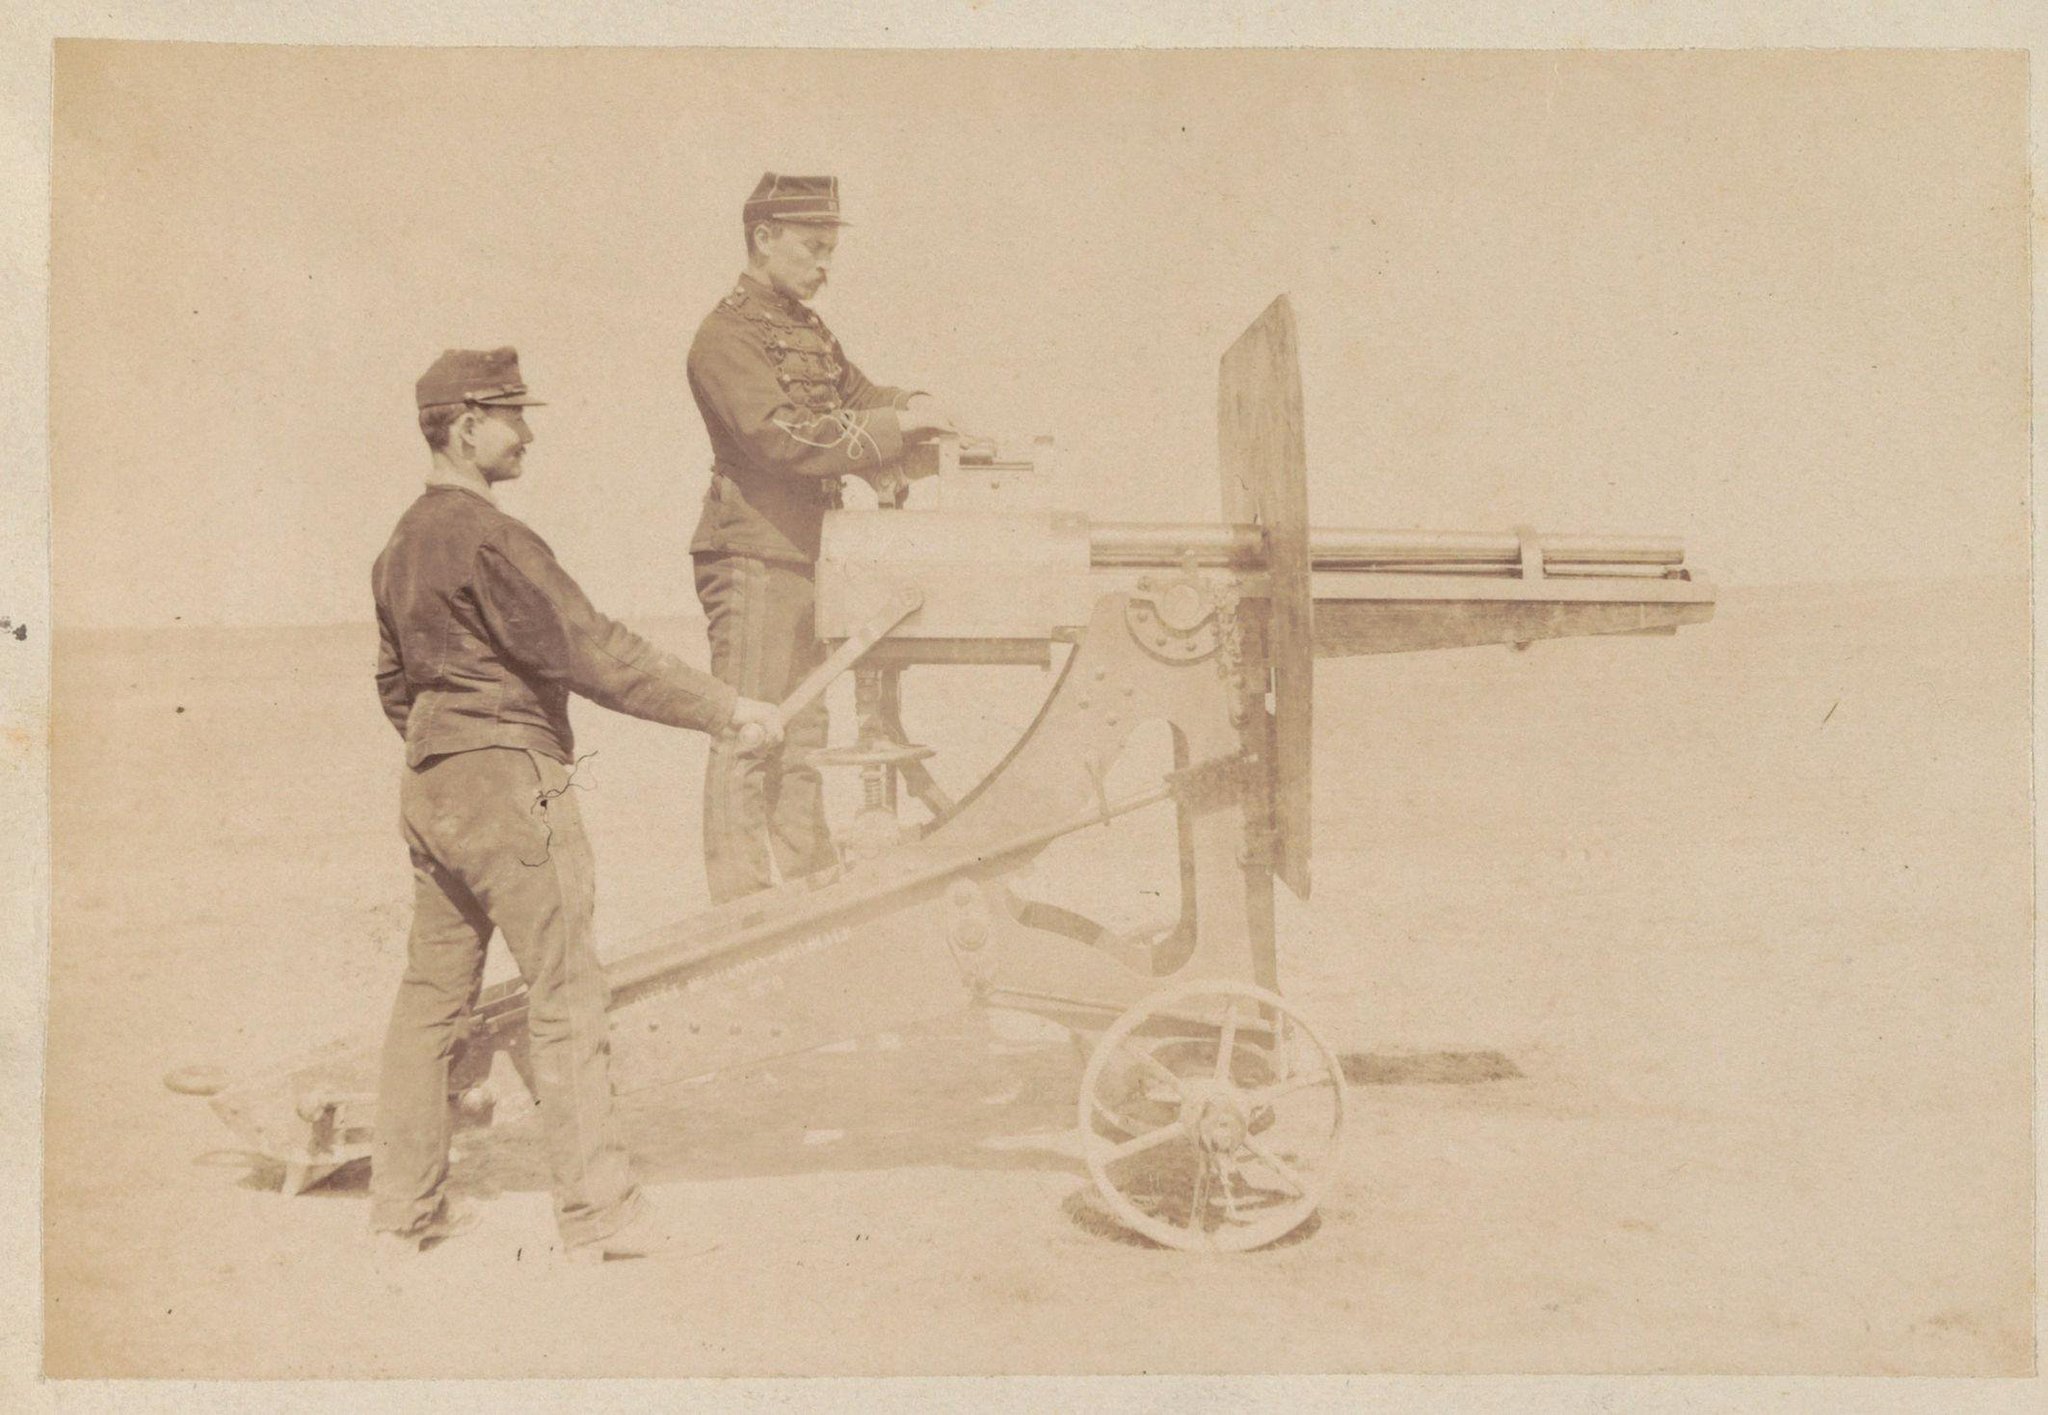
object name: photograph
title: Twee Franse militairen achter een licht kanon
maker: Anonymous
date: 1805-1884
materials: photographic support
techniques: albumen print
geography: france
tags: land forces (+ artillery), firearms: cannon (+ land forces), france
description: Onderdeel van Album van een Franse amateurfotograaf met opnames van familie, militairen, industrie, landschappen en bezienswaardigheden in Frankrijk.